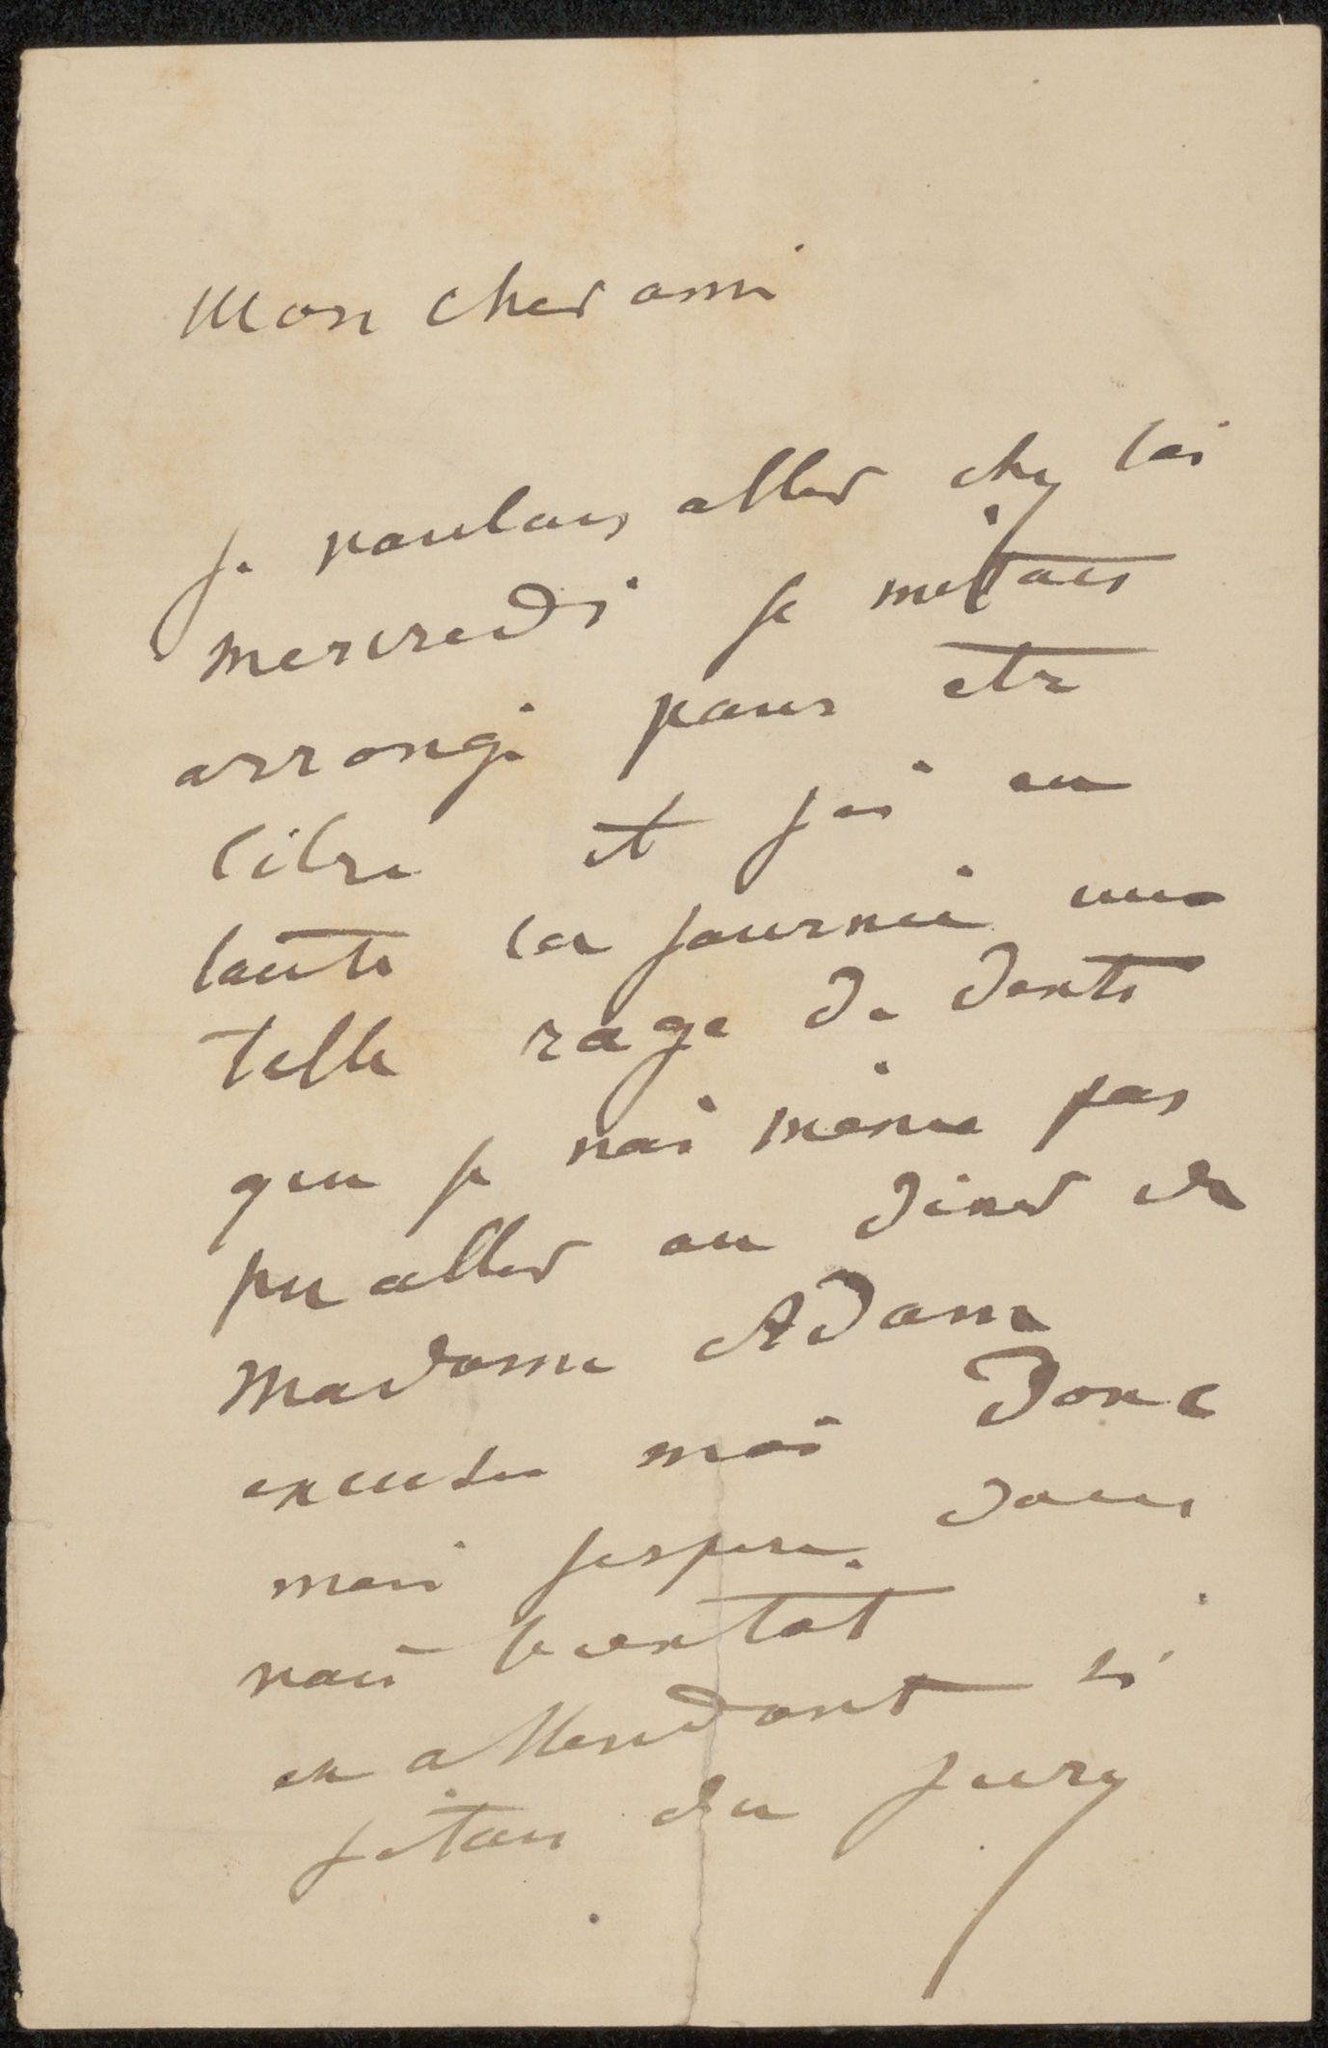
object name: letter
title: Brief aan anoniem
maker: h. henner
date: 1867-1930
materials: ink, paper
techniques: pen, writing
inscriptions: collector's mark: ‘RPK’, watermark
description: Brief is bewaard bij correspondentie aan Philip Zilcken.